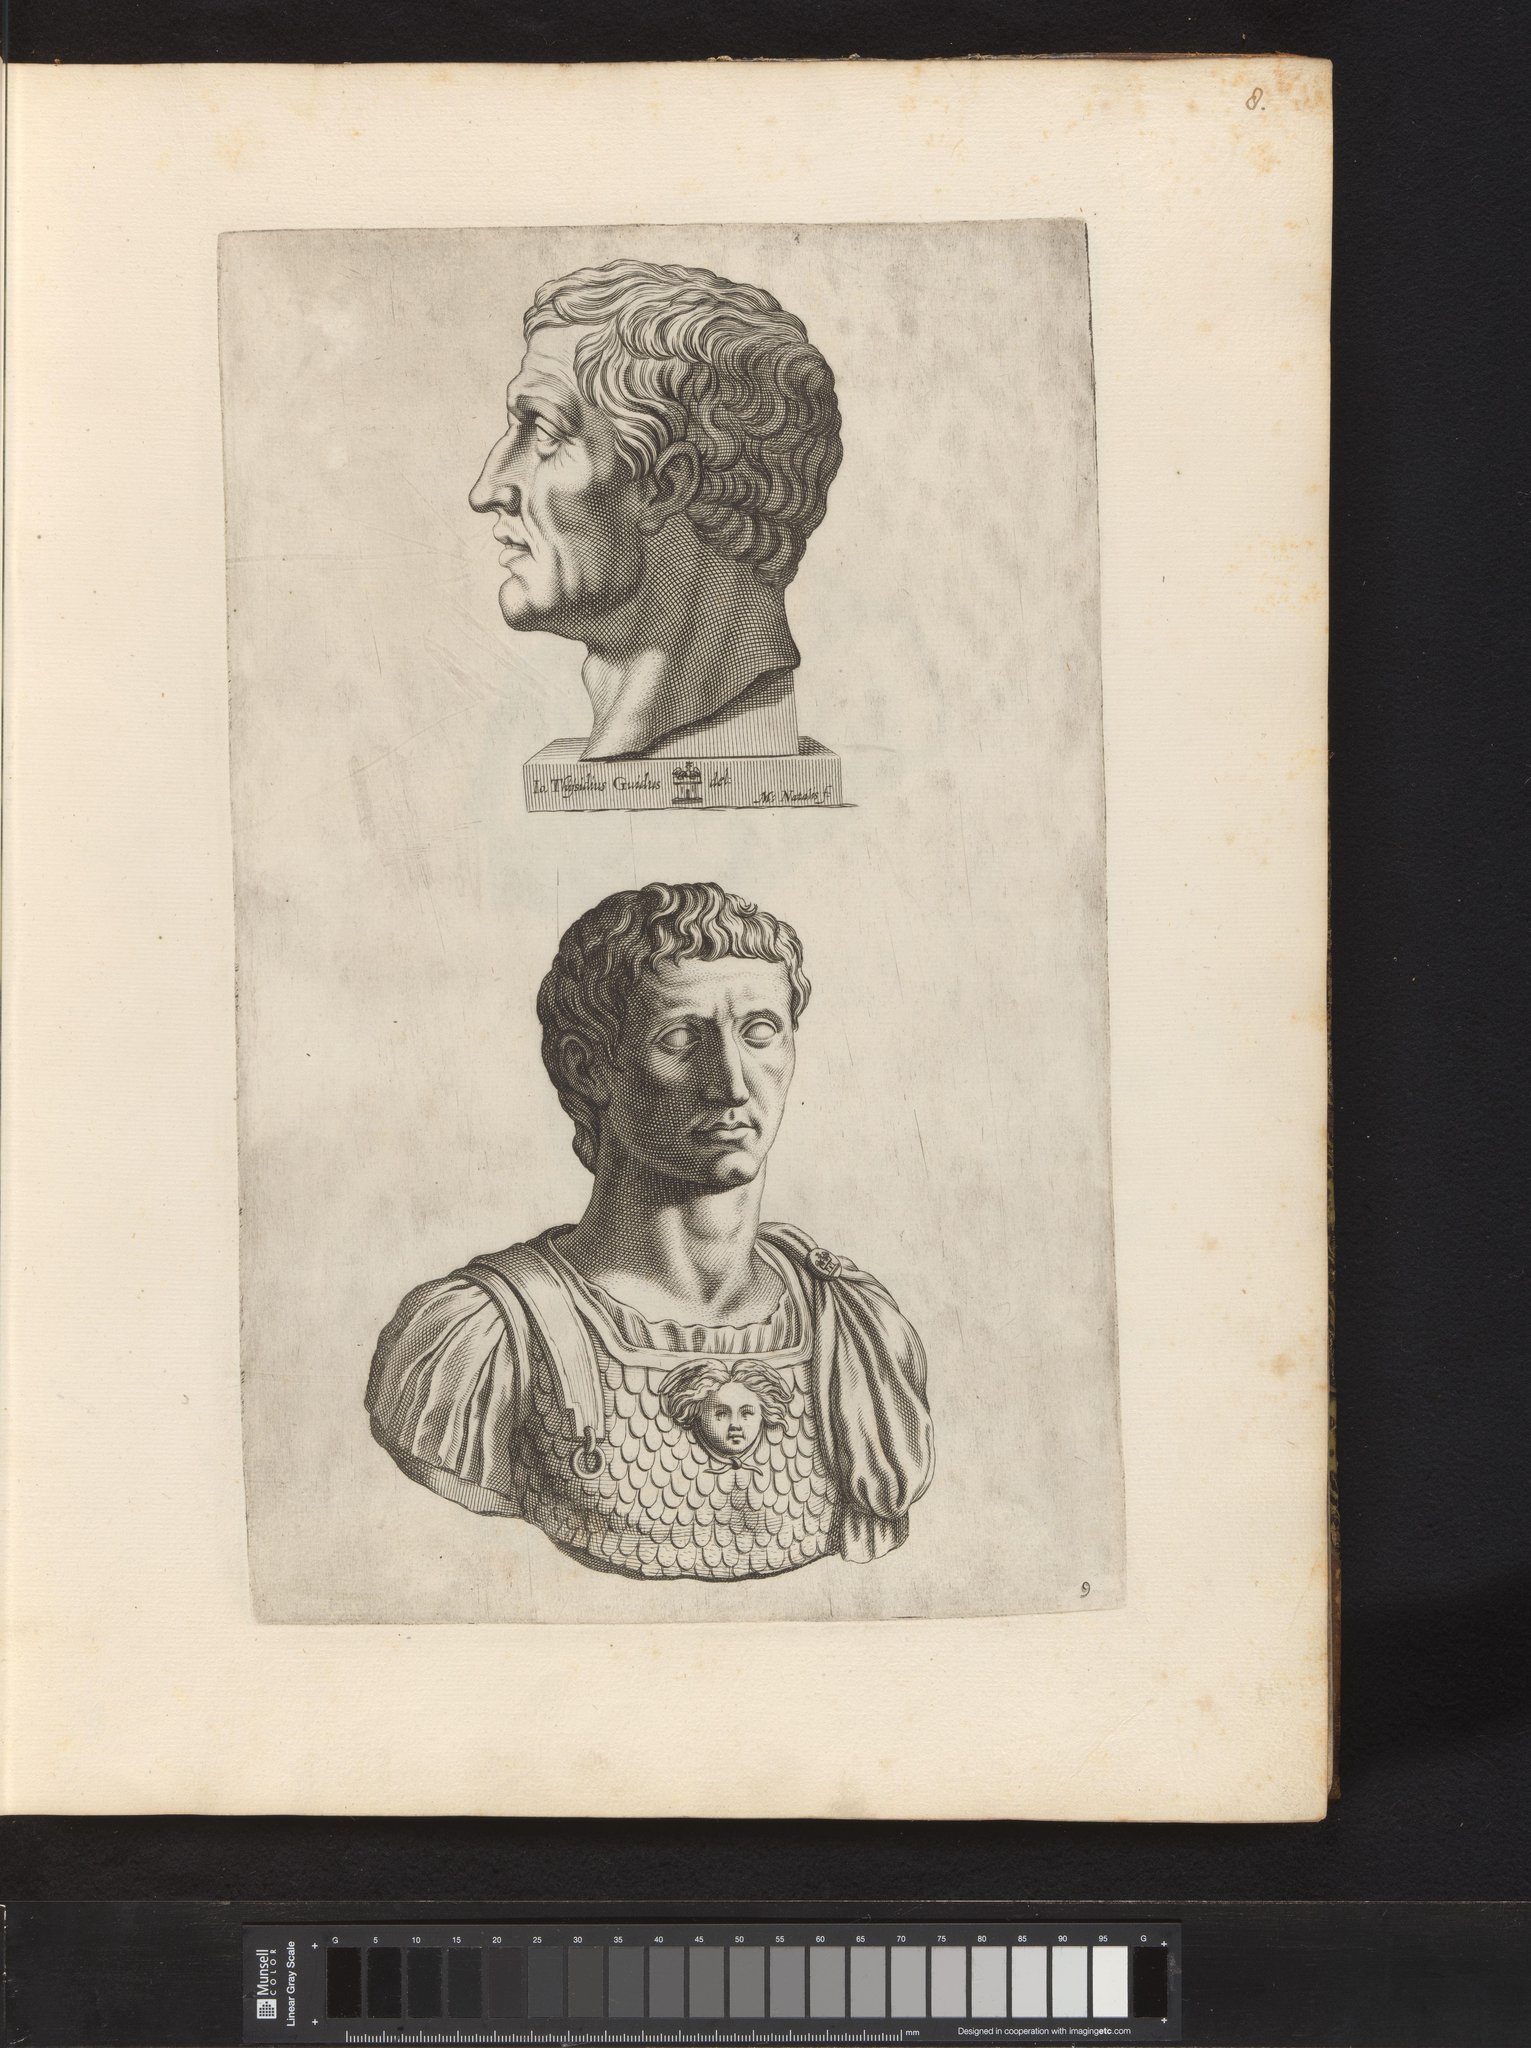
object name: print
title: Portretbustes van Claudius en Caligula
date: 1636-1647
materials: paper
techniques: engraving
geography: rome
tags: germany, rome, male persons from classical history (+ head, bust, etc.), piece of sculpture, reproduction of a piece of sculpture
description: Twee Romeinse sculpturen van Claudius en Caligula. Boven de buste, het hoofd naar links gewend. Op het medaillon op zijn schouder het wapenschild van Vincenzo Giustiniani. Onder de buste van een man, gekleed in borstkuras, en profil naar rechts. Prent maakt deel uit van een album met een serie prenten naar de sculpturen in de verzameling in de Galleria Giustiniani te Rome.